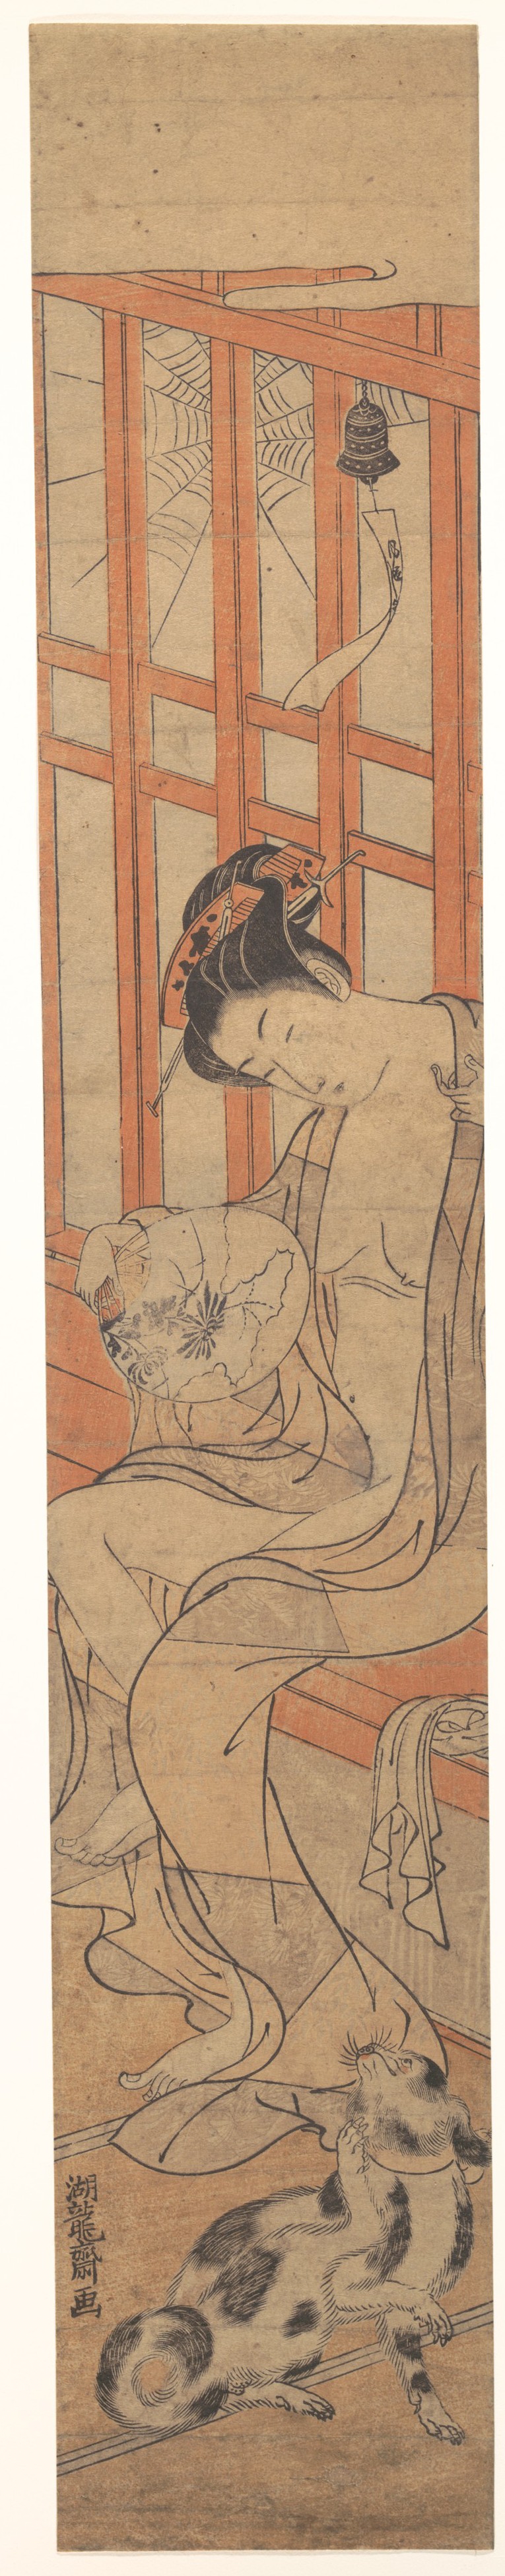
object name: print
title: Woman Fanning Herself After a Bath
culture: japanese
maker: isoda koryūsai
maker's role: artist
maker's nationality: japanese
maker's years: 1735-1790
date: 1767-1800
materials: ink, paper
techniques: hashira, woodblock print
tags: animals,fans,women